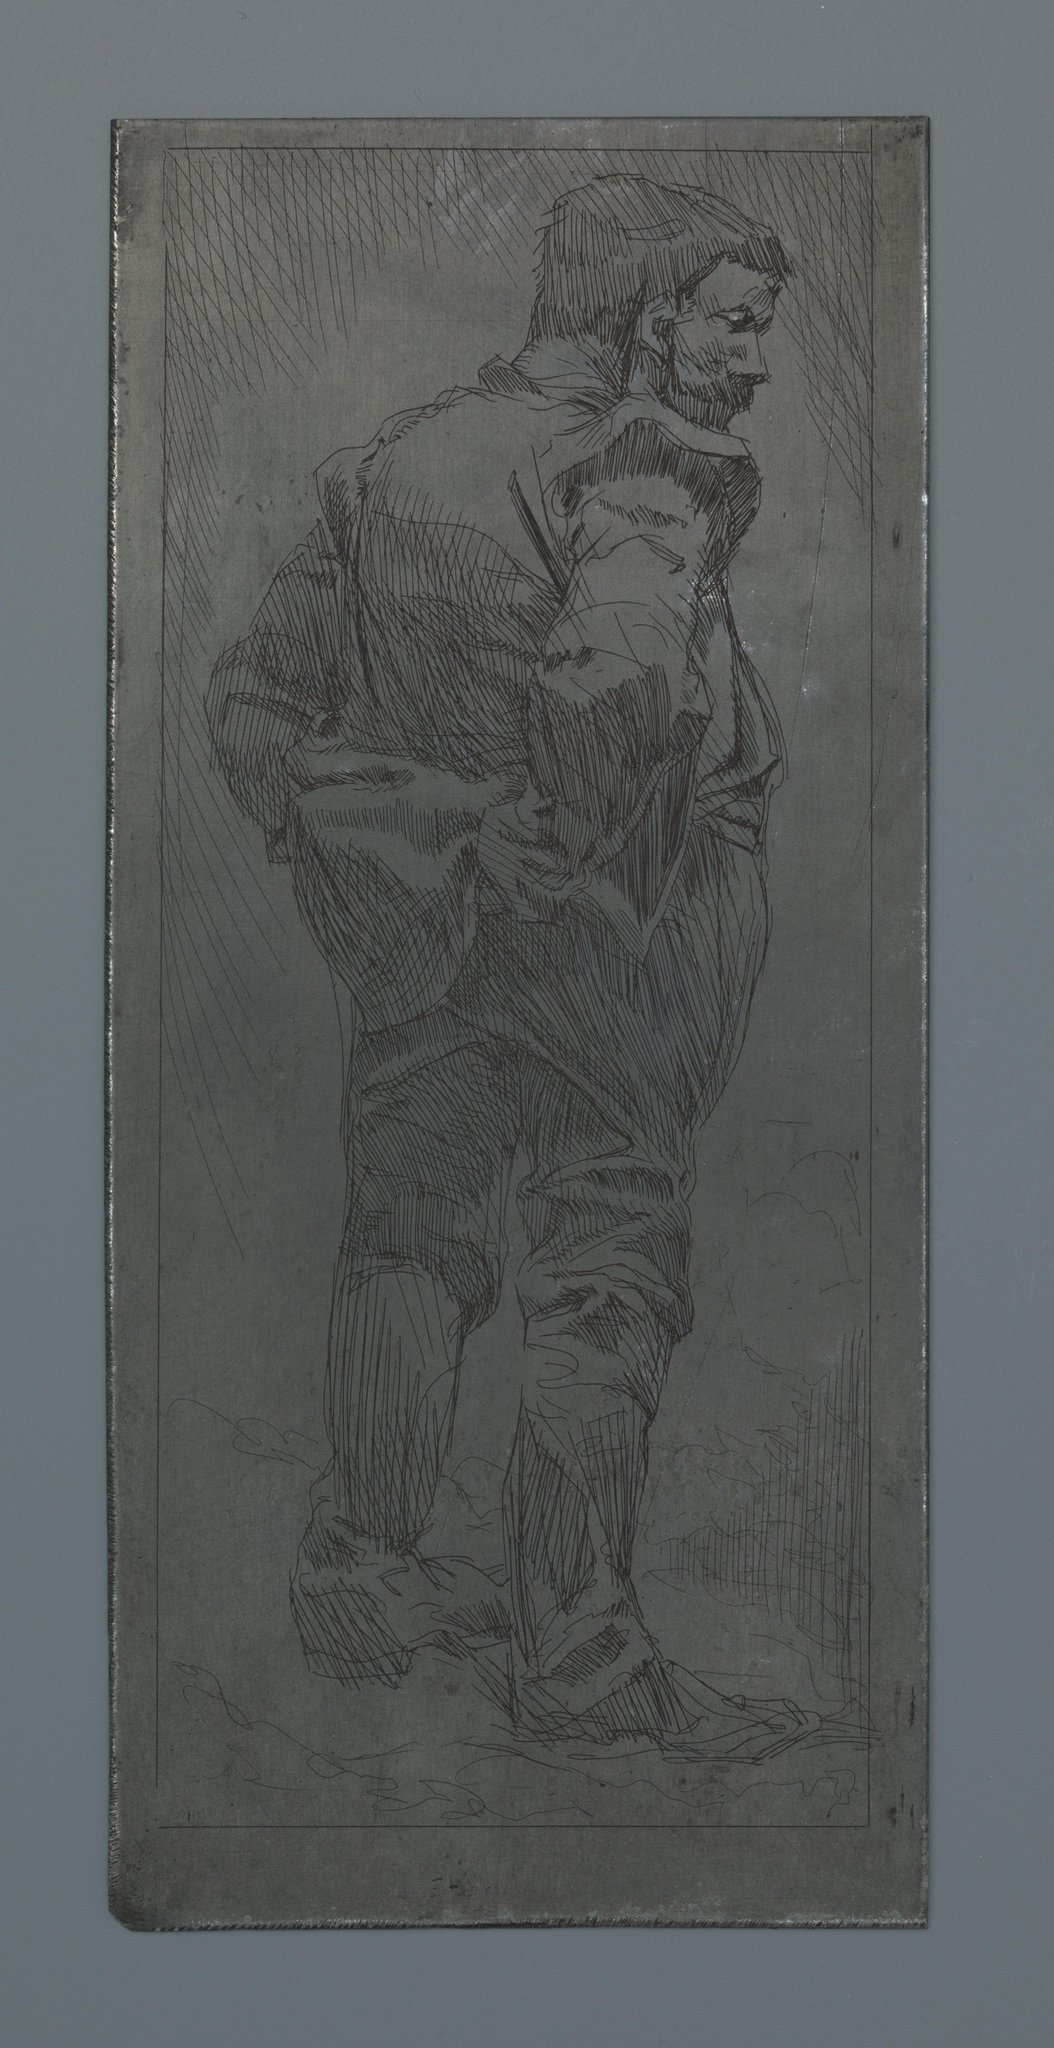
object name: zinkplaat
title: Man met handen op zijn rug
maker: johannes josephus aarts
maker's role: draughtsman, print maker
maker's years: 1871-1934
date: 1881-1934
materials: zinc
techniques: etching